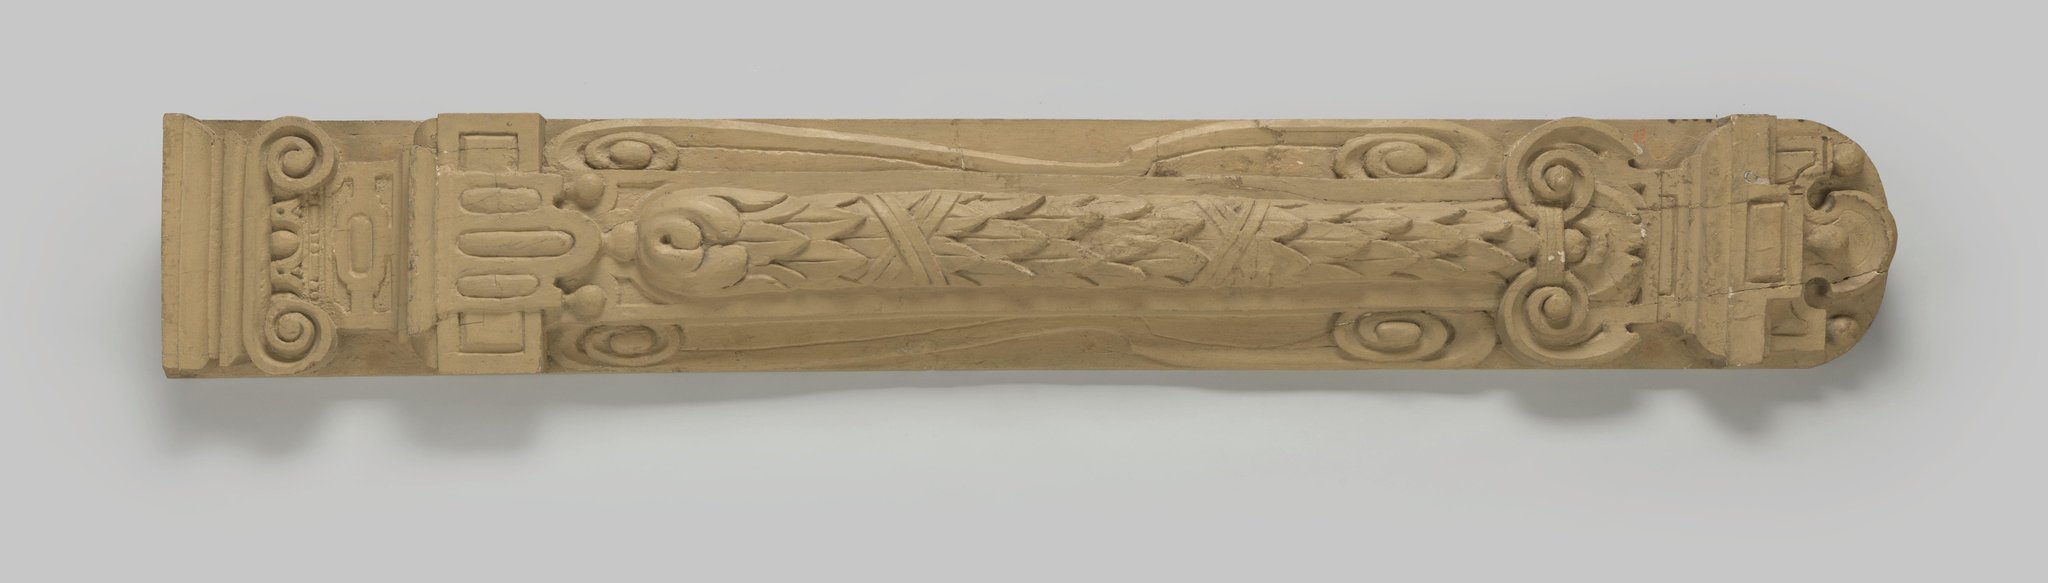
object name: stile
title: Gebeeldhouwde stijl van eikenhout, afkomstig uit het z.g. Huis van Alva, Warmoestraat te Amsterdam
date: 1500-1699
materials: wood, paint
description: Gebeeldhouwde eikenhouten stijl, afkomstig uit het z.g. Huis van Alva, Warmoestraat te Amsterdam. In totaal gaat het om zes beschilderde stijlen (zie BK-KOG-754-1, 2, 4 t/m 7). Zie tevens BK-KOG-755-A t/m H, dit zijn twee kapitelen en zes stijlen van onbehandeld eikenhout die uit hetzelfde huis afkomstig zijn.